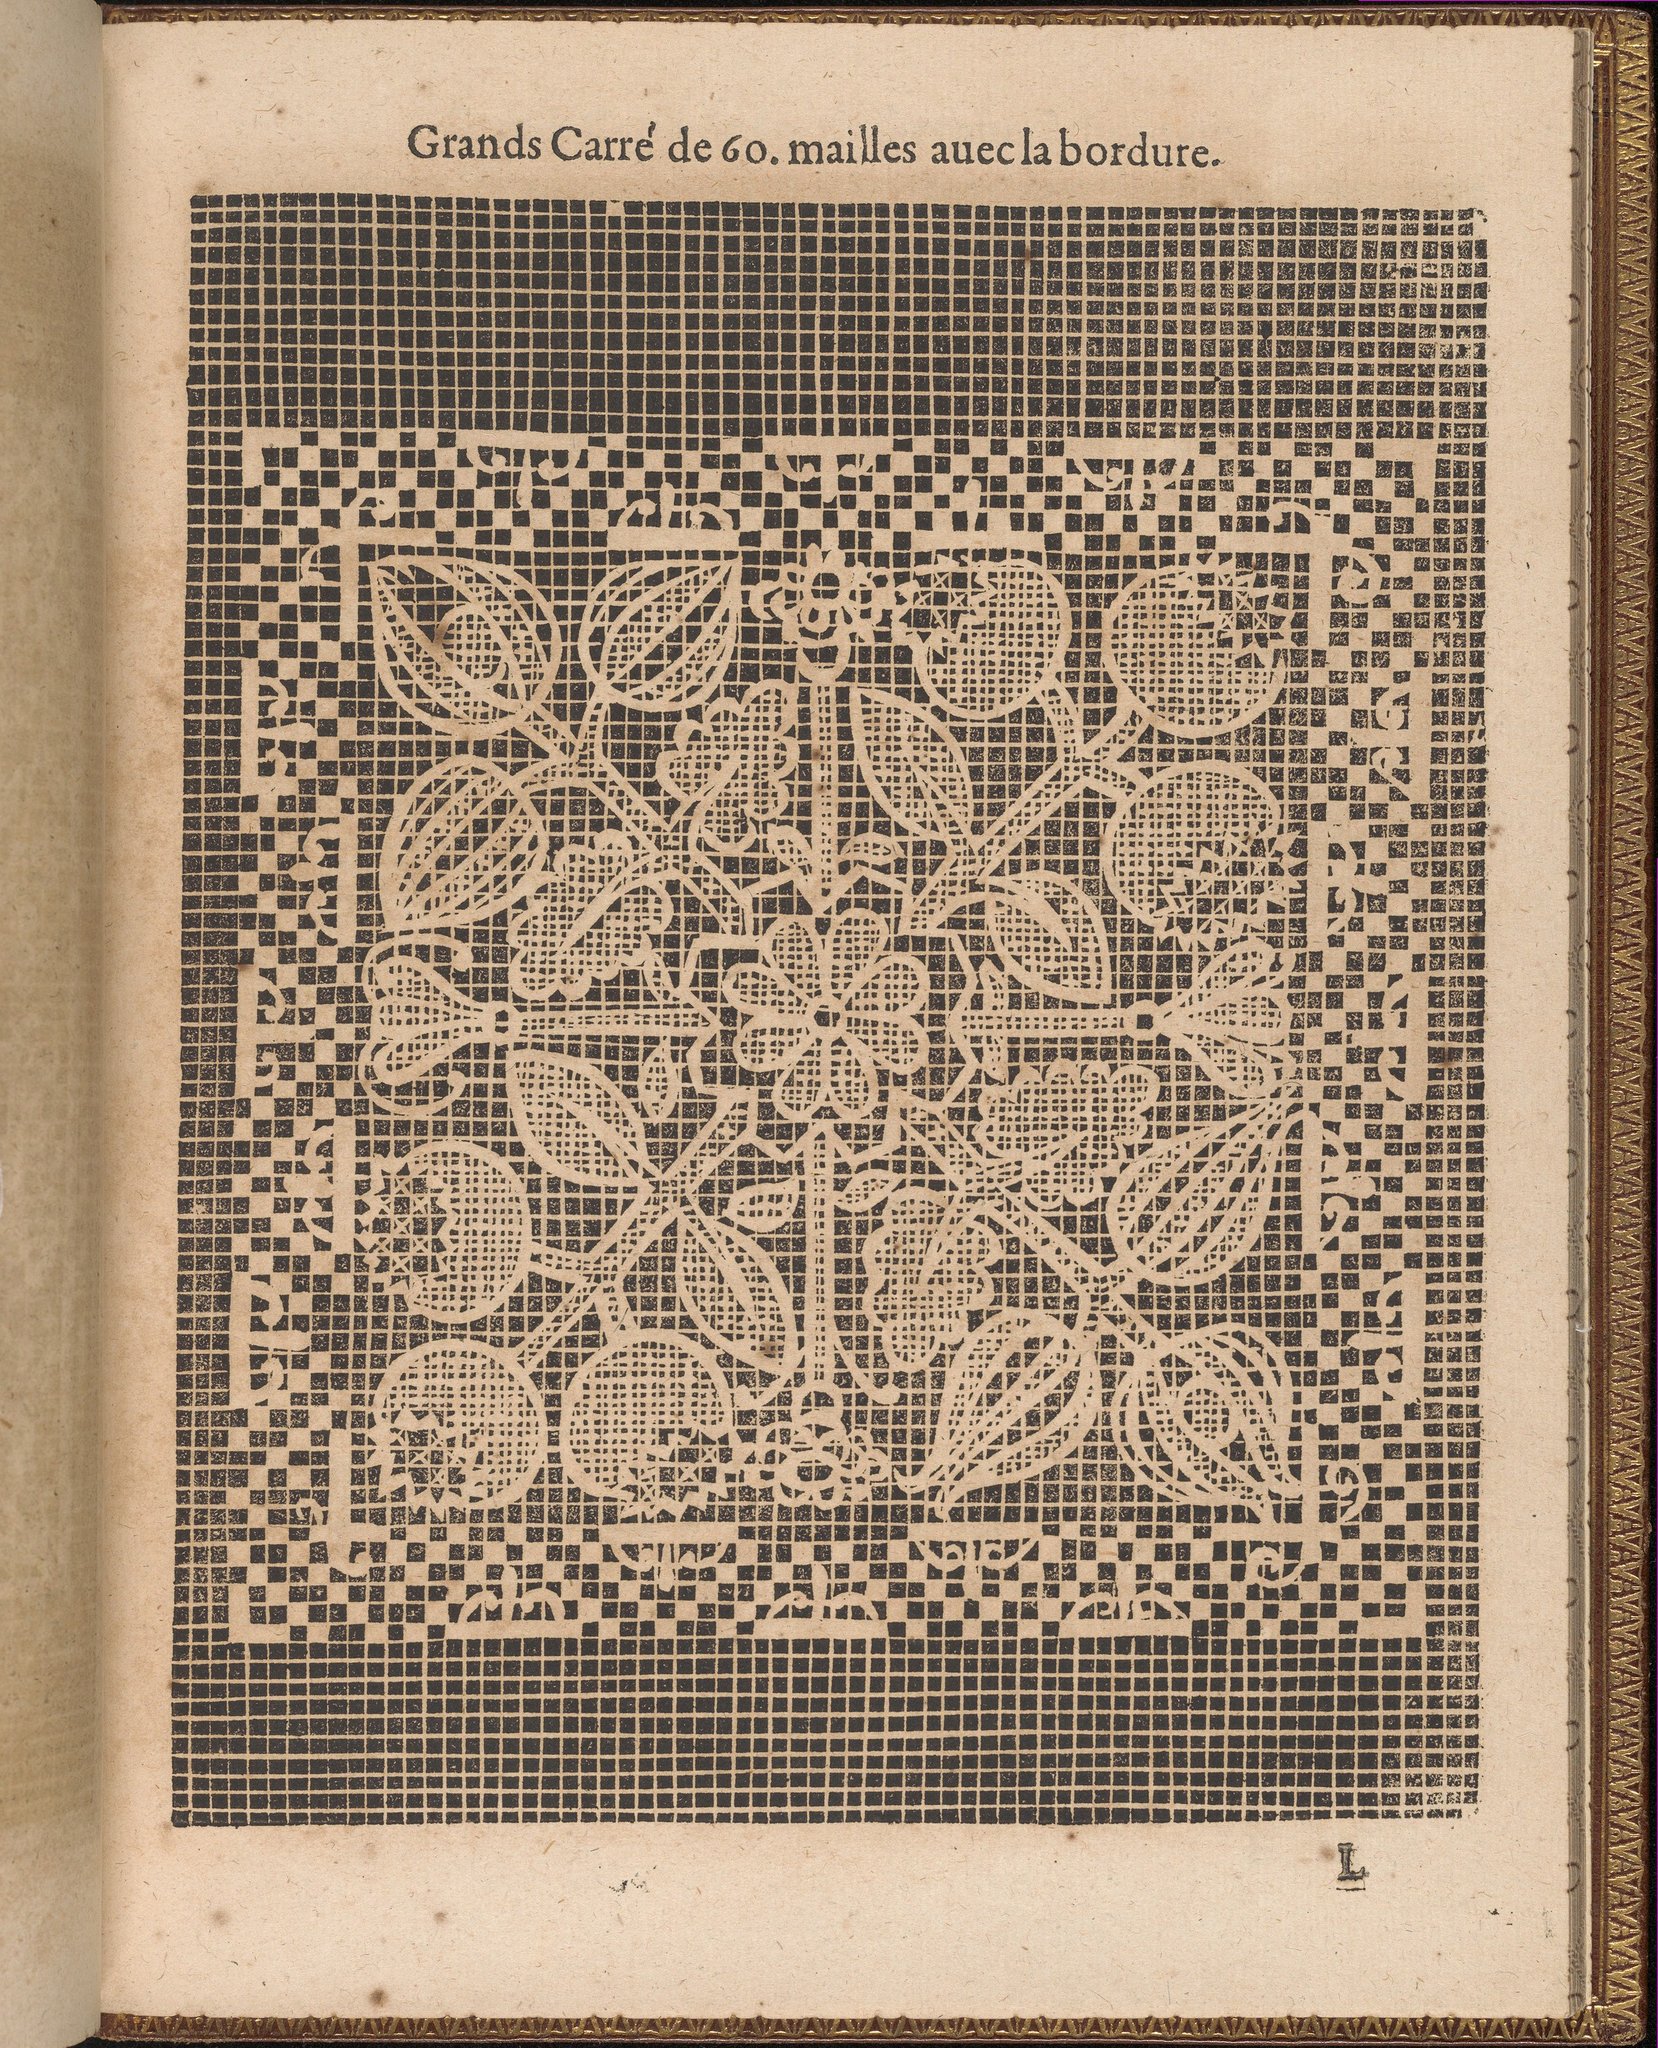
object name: book print ornament architecture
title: La Pratique de l'Aiguille, page 40 (recto)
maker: matthias mignerak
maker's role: author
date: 1605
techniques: woodcut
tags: ornament,fruit